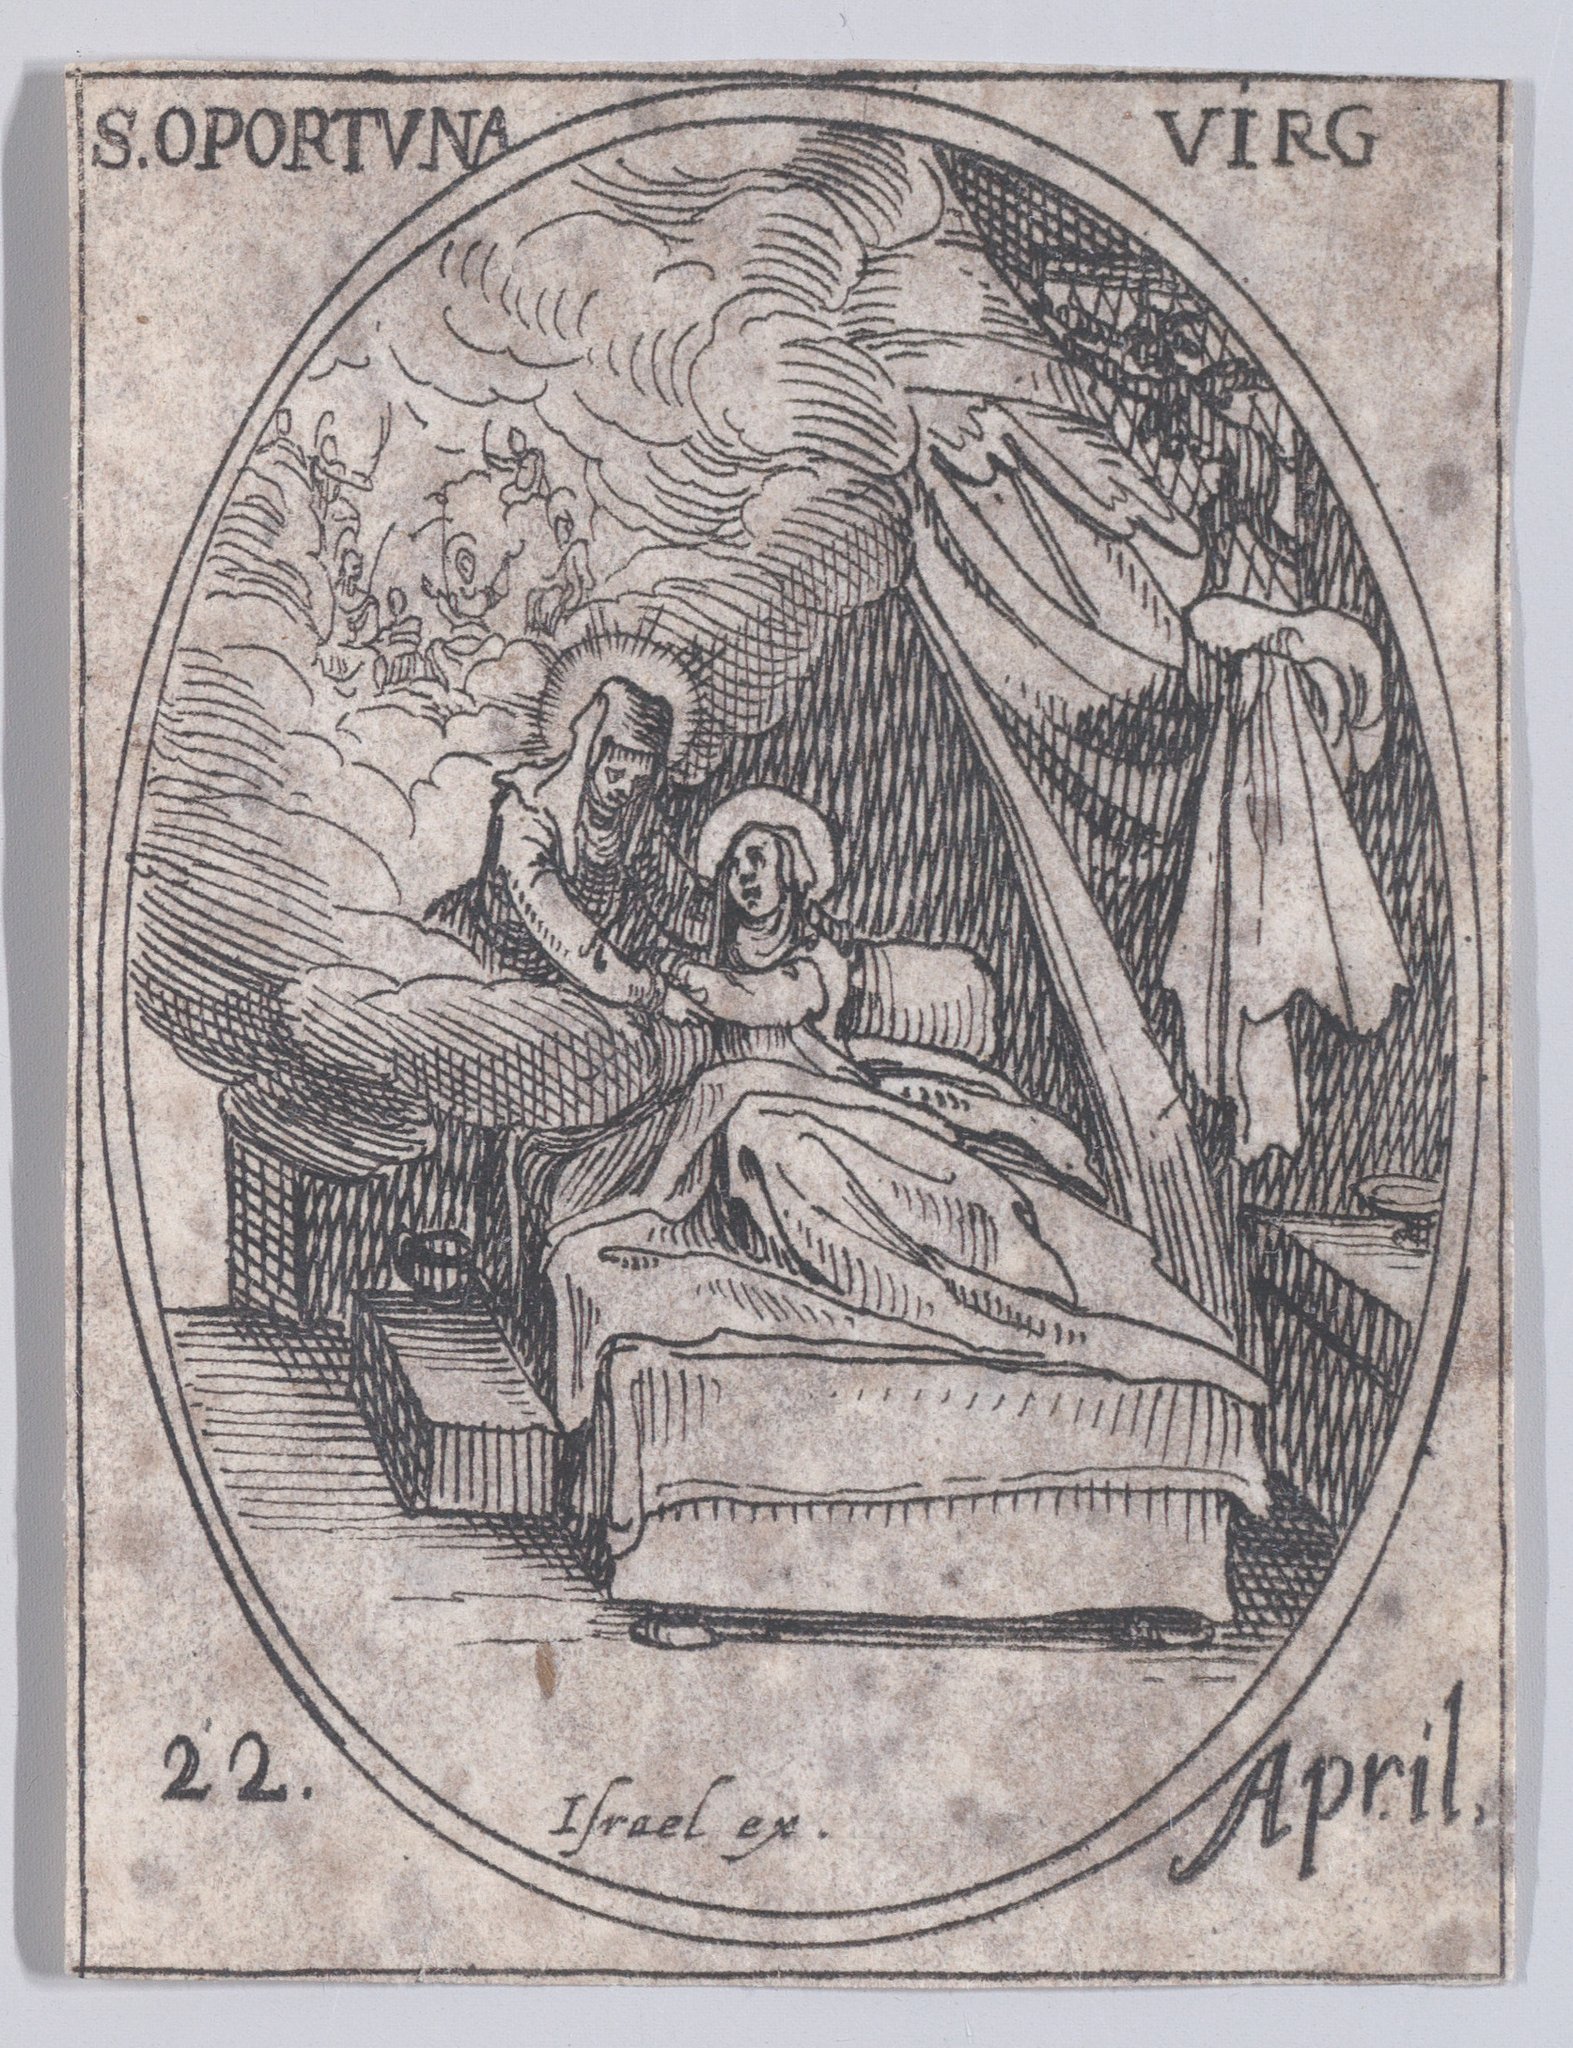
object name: print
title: Ste. Opportune, vierge (St. Opportuna, Virgin), April 22nd, from "Les Images De Tous Les Saincts et Saintes de L'Année" (Images of All of the Saints and Religious Events of the Year)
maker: jacques callot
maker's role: artist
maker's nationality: french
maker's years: 1592-1635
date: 1636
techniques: etching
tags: women,saints,beds